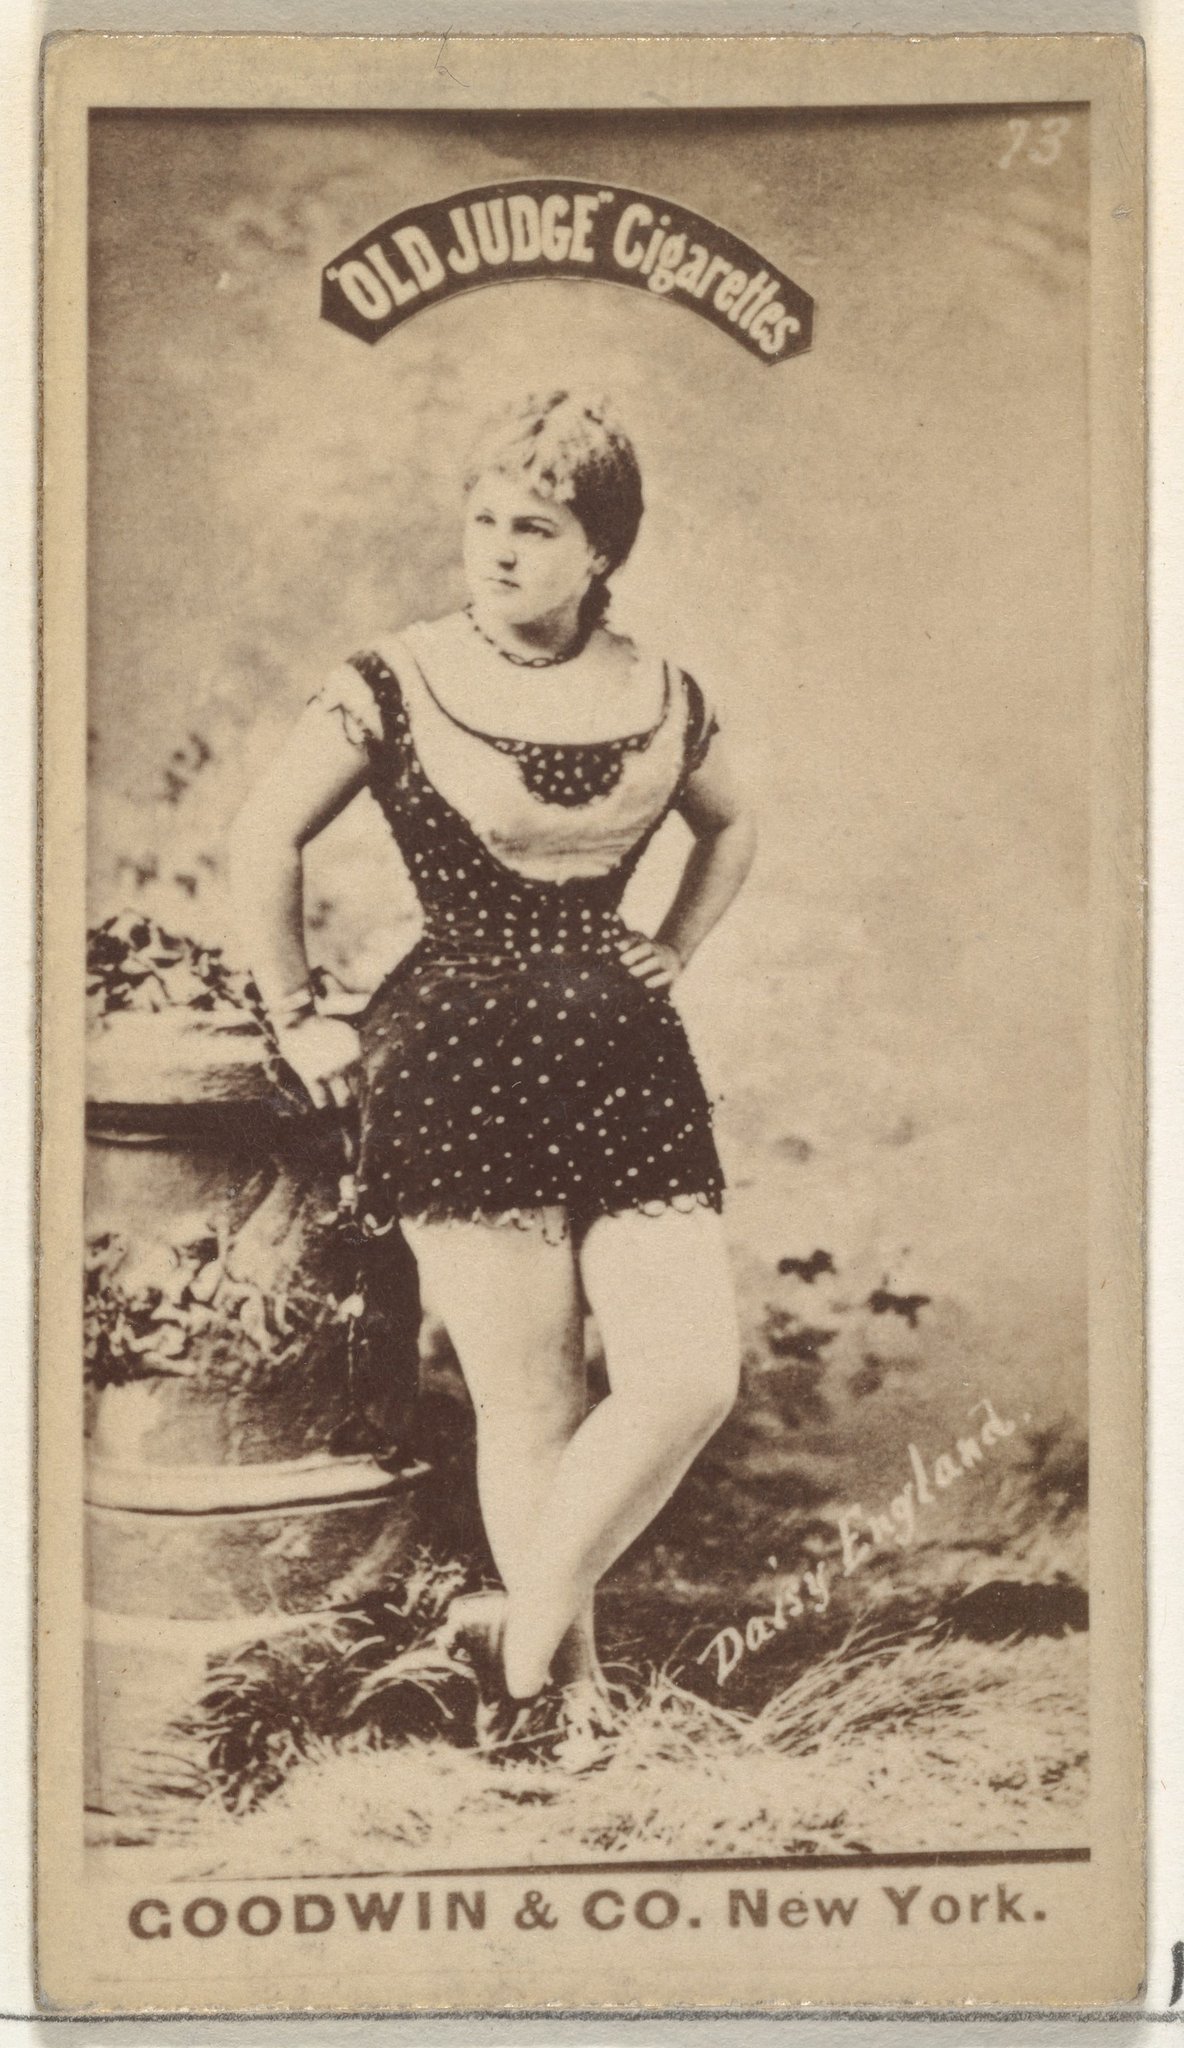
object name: photograph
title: Daisy England, from the Actors and Actresses series (N171) for Old Judge Cigarettes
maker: goodwin & company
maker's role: publisher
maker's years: 1850-1950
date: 1886-1890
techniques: albumen silver print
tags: portraits,women,actresses